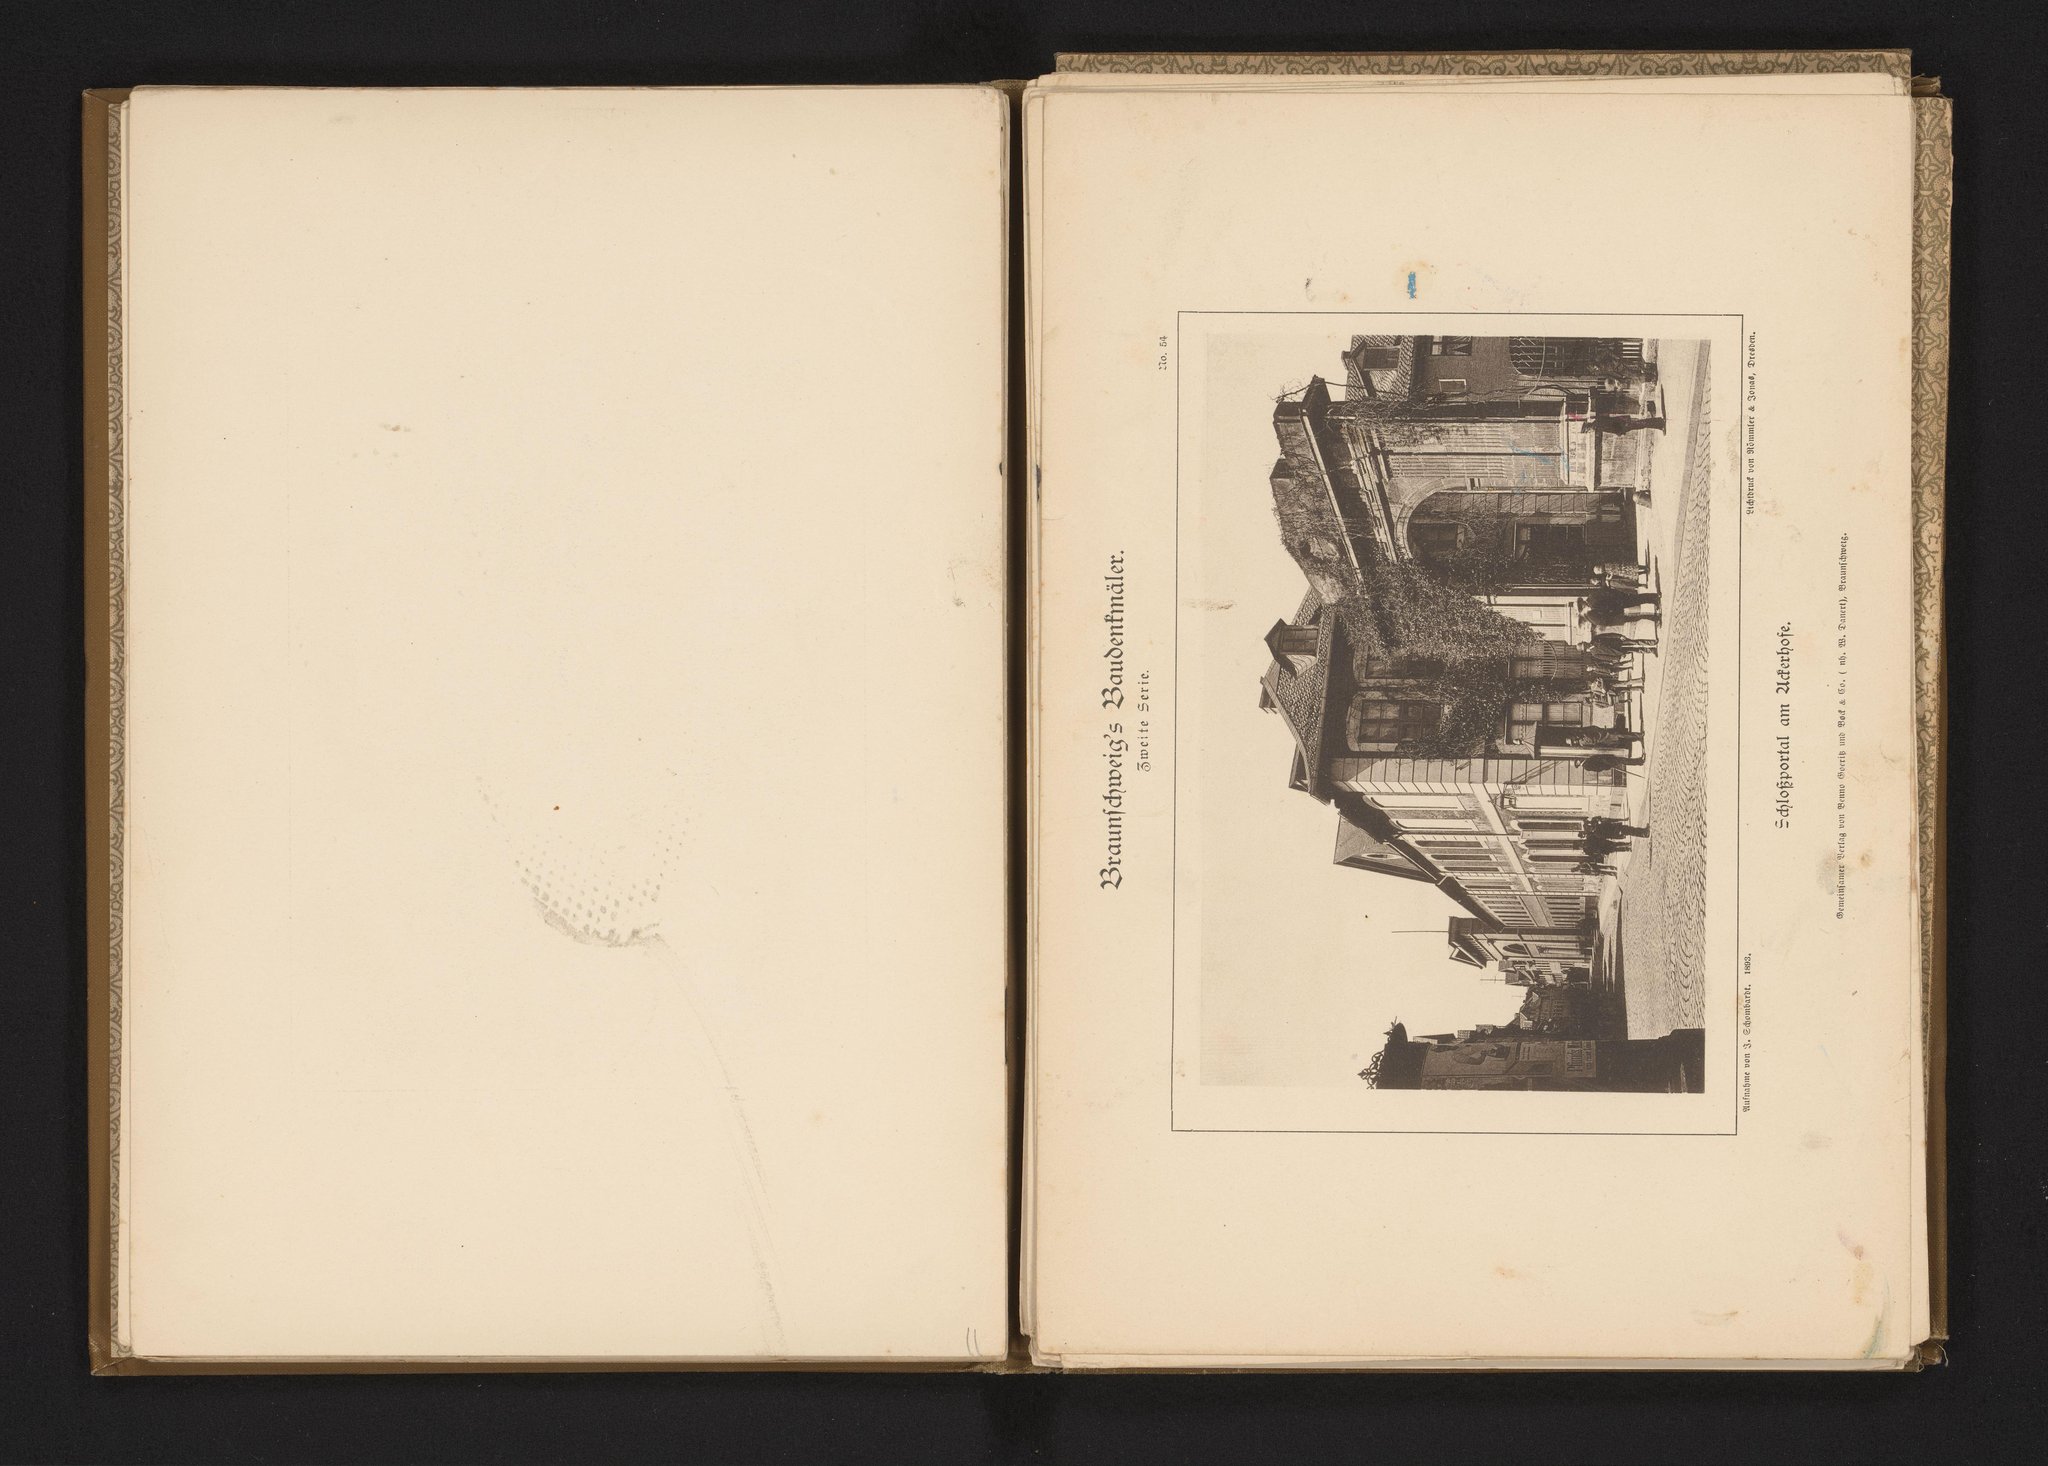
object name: photomechanical print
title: Braunschweig's Baudenkmäler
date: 1893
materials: paper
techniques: photograph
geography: dresden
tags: arch, archivolt ~ architecture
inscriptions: number: ‘No. 54.’